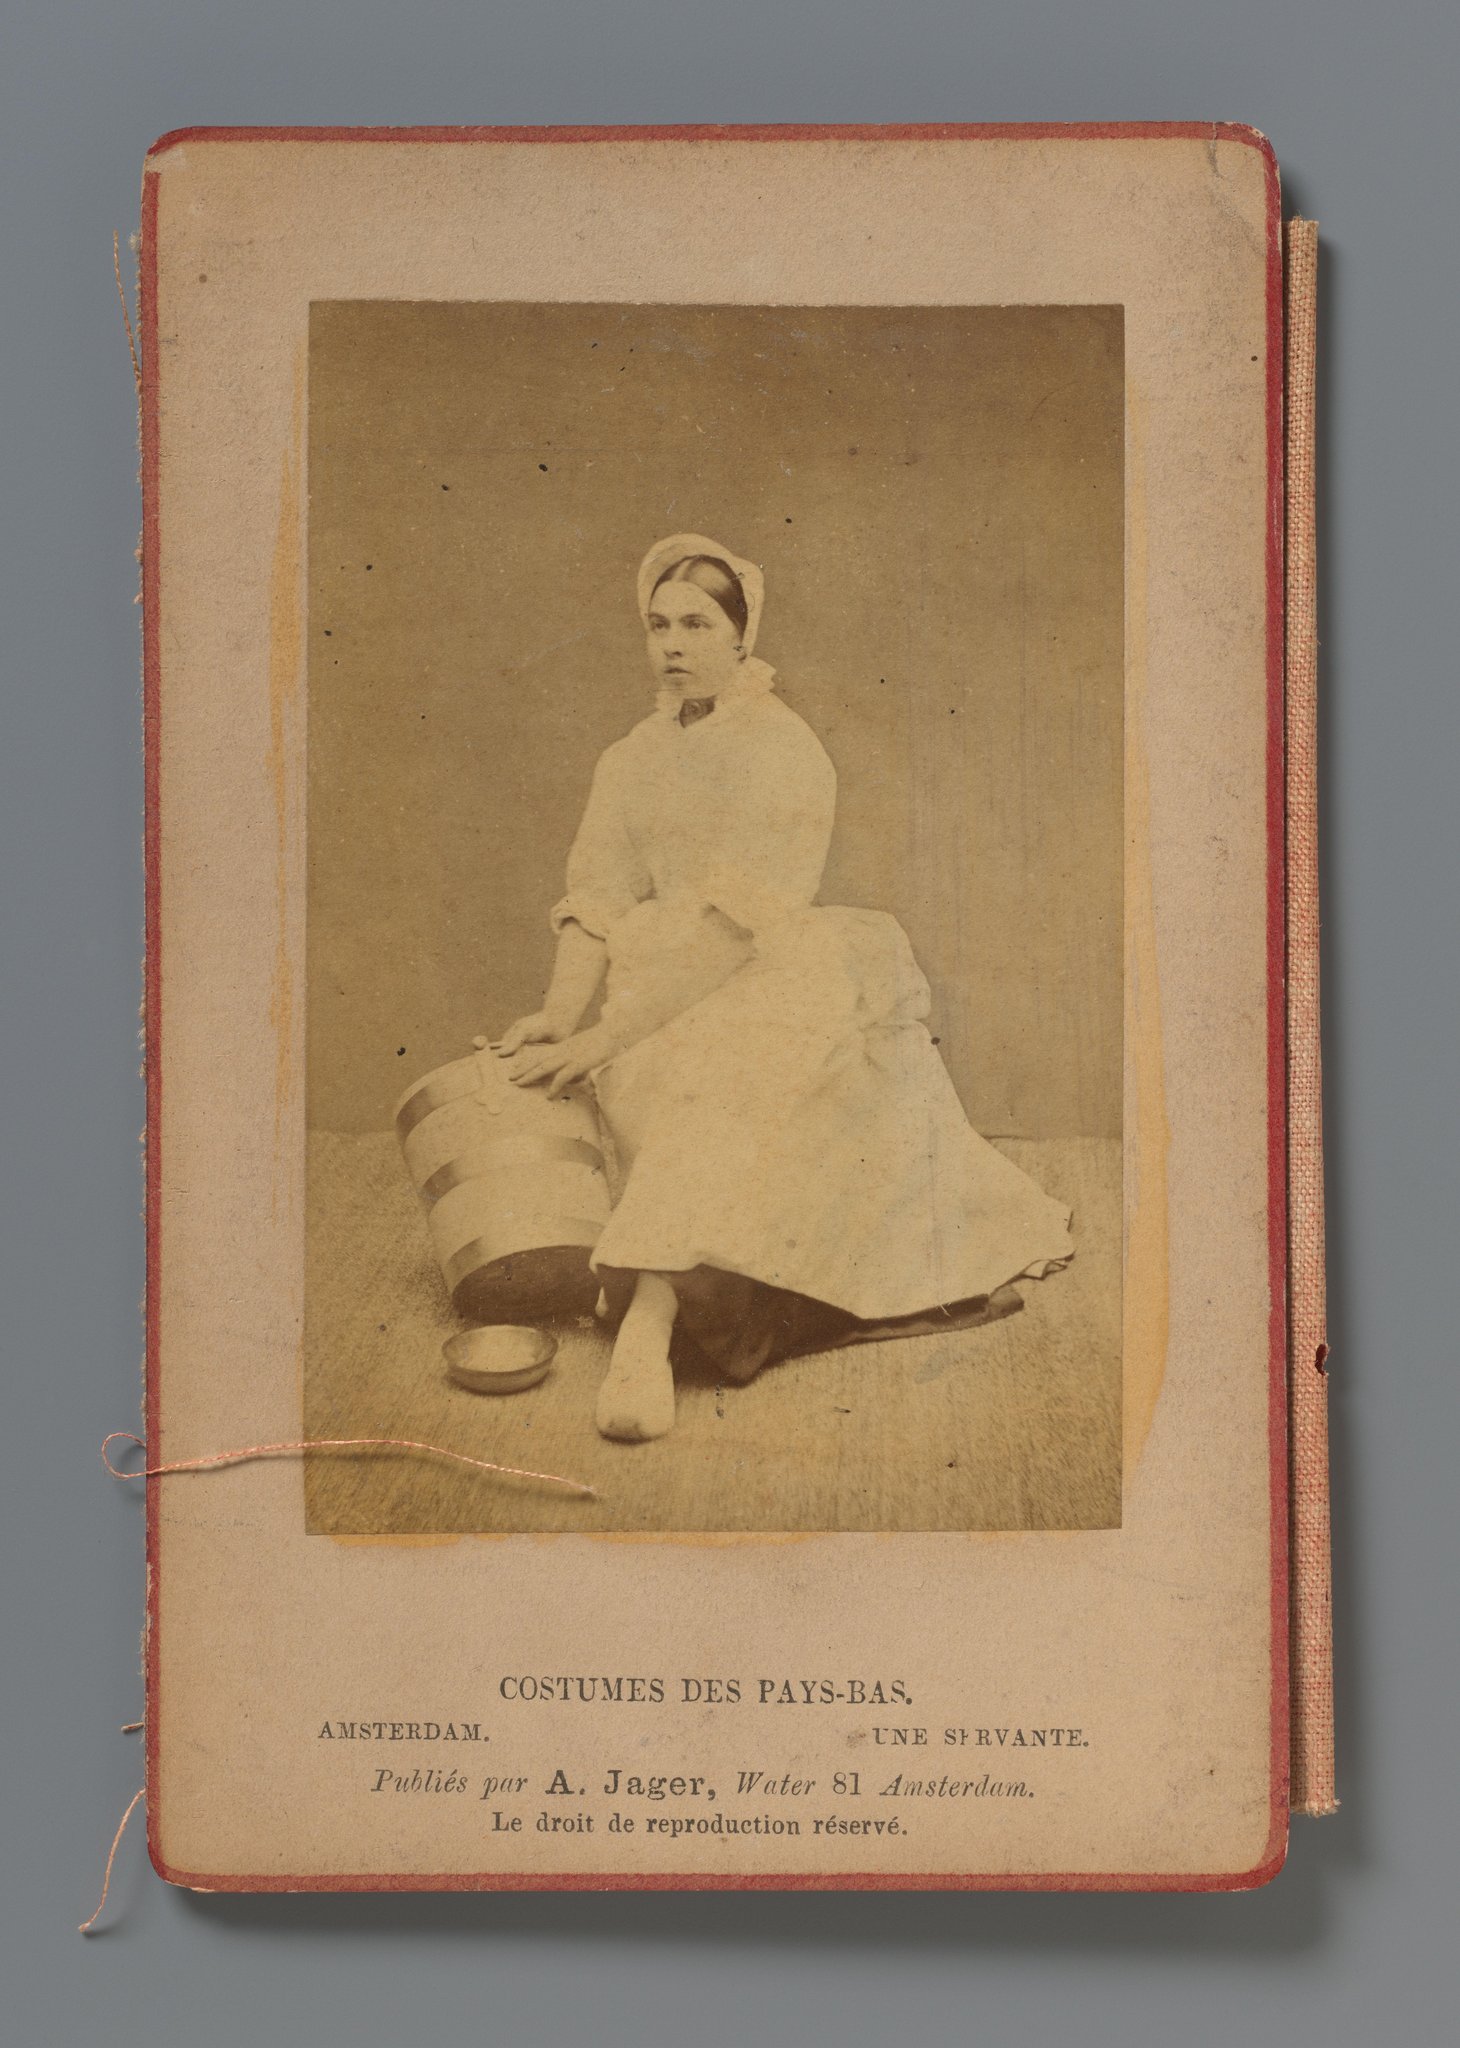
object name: photograph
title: Amsterdam. Une servante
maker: andries jager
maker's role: publisher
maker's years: 1825-1905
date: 1855-1870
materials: cardboard, linen, paper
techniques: albumen print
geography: netherlands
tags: historical persons not known by name - bb - woman, maid ~ house personnel, amsterdam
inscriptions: inscription: ‘Le droit de reproduction réservé.’